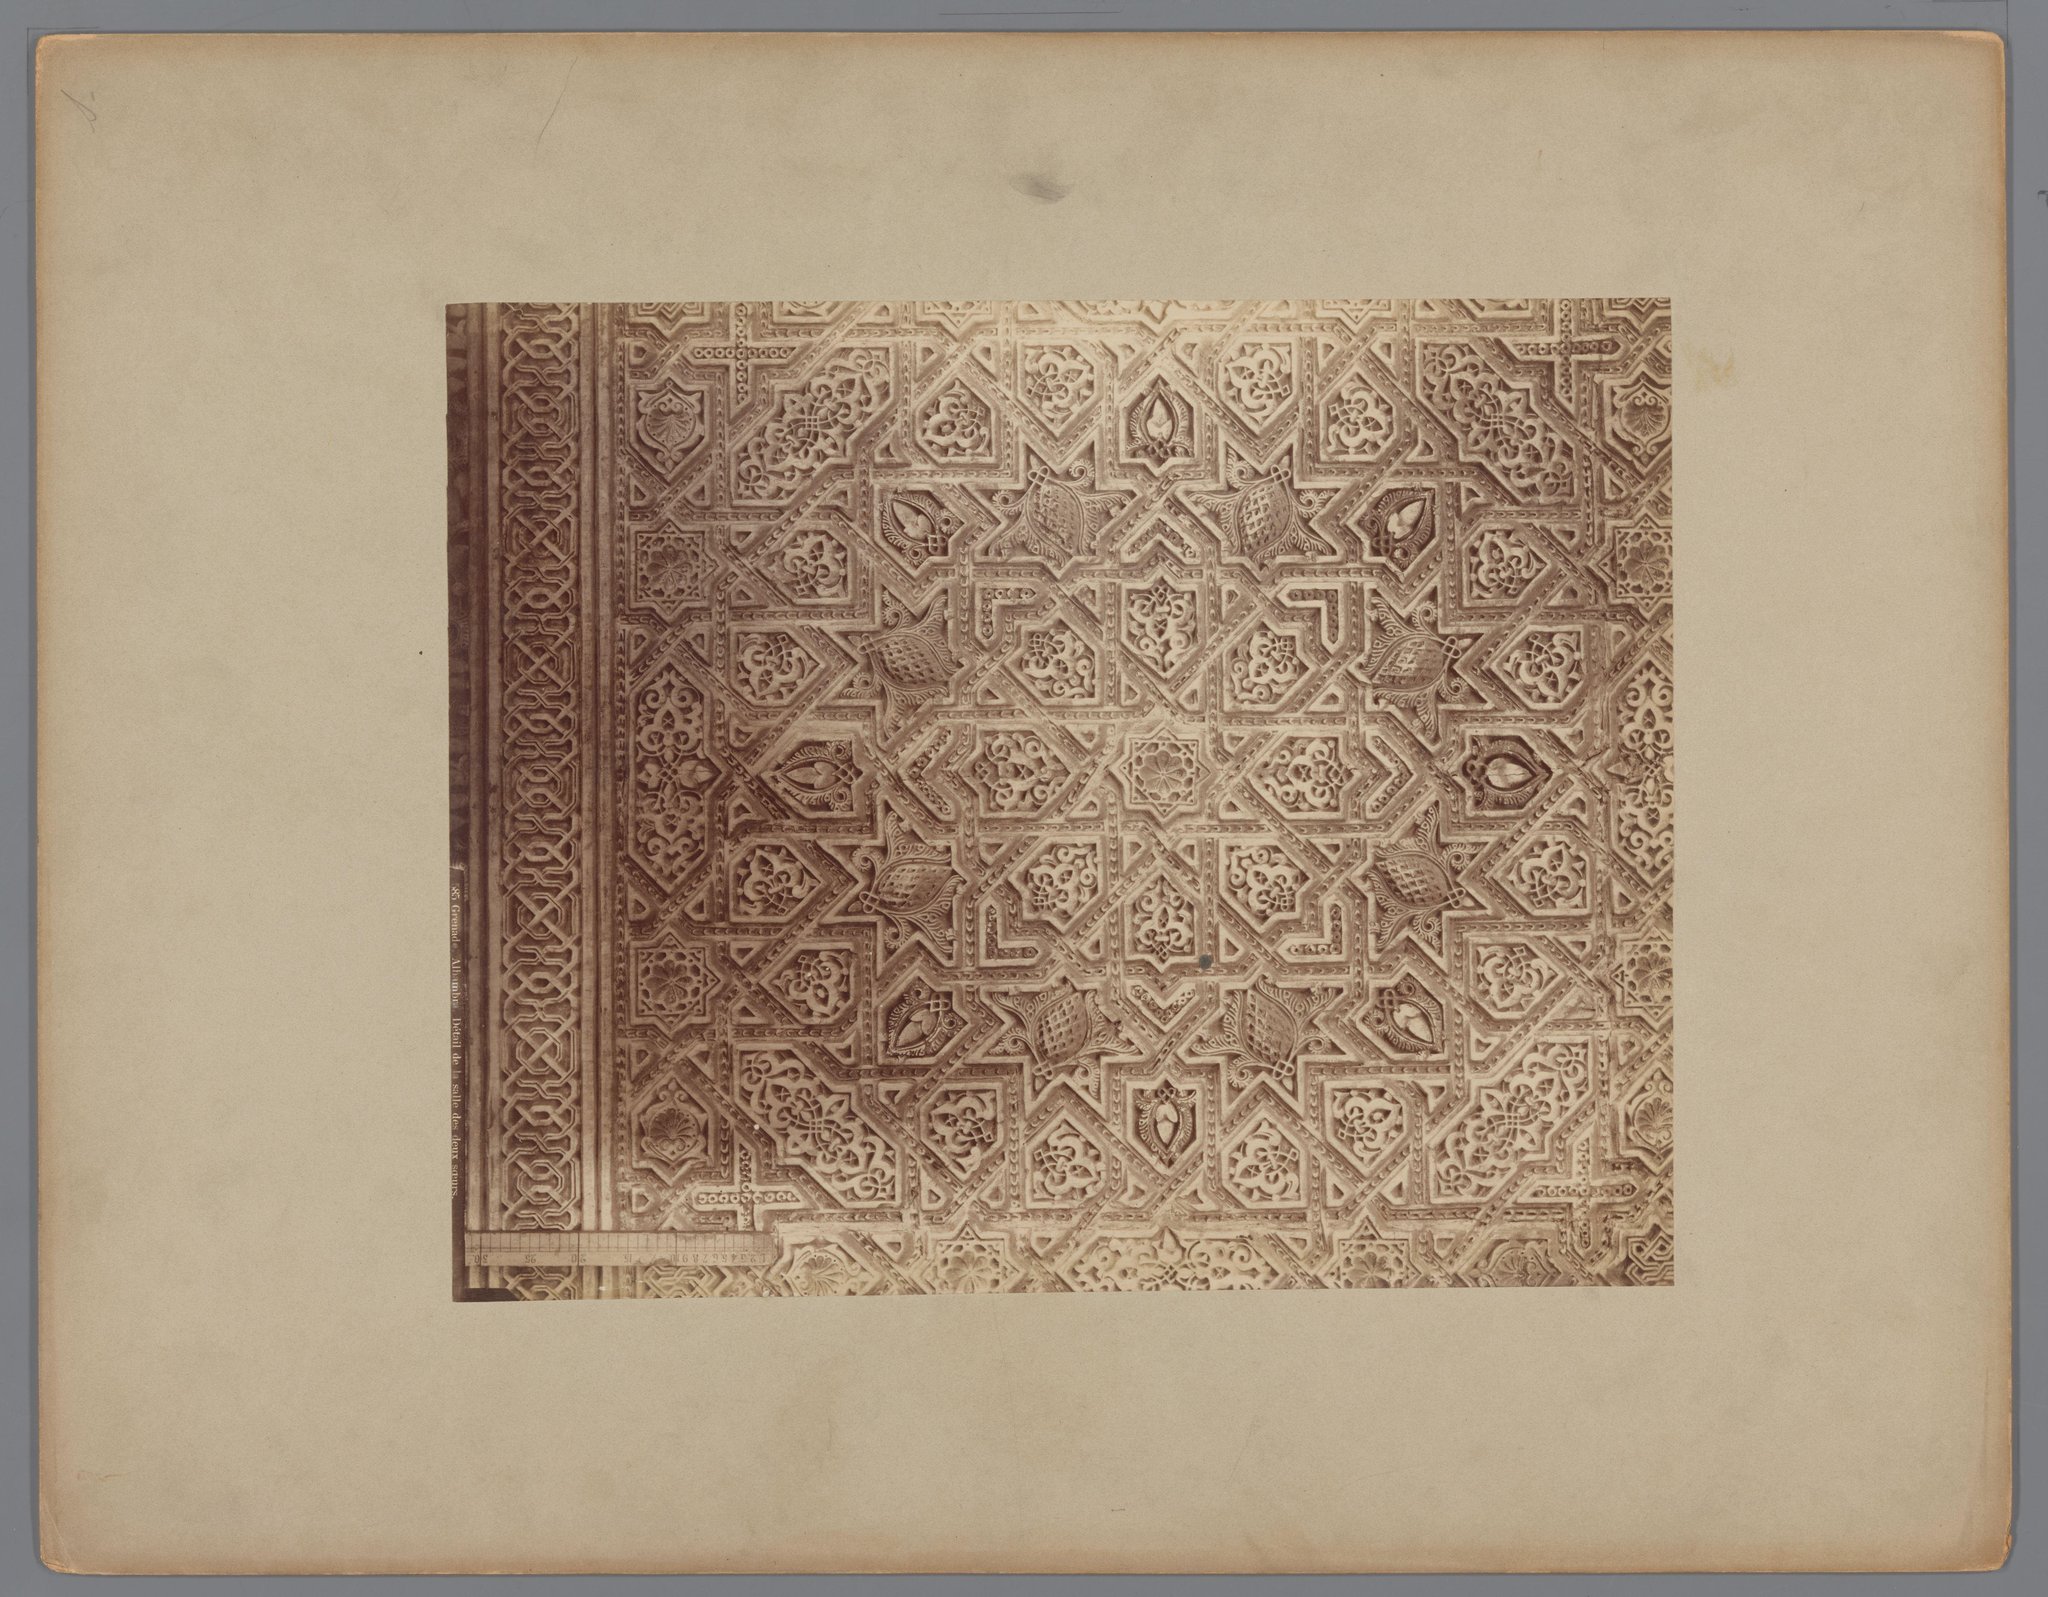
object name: photograph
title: Wandversiering van de Zaal van de Twee Zusjes in het Alhambra te Granada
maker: Anonymous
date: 1875-1900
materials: cardboard, photographic support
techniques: albumen print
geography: alhambra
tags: fortress, flat decoration ~ applied arts (+ islamic art), interior ~ representation of a building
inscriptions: collector's mark: Lugt 3937, number: ‘585’